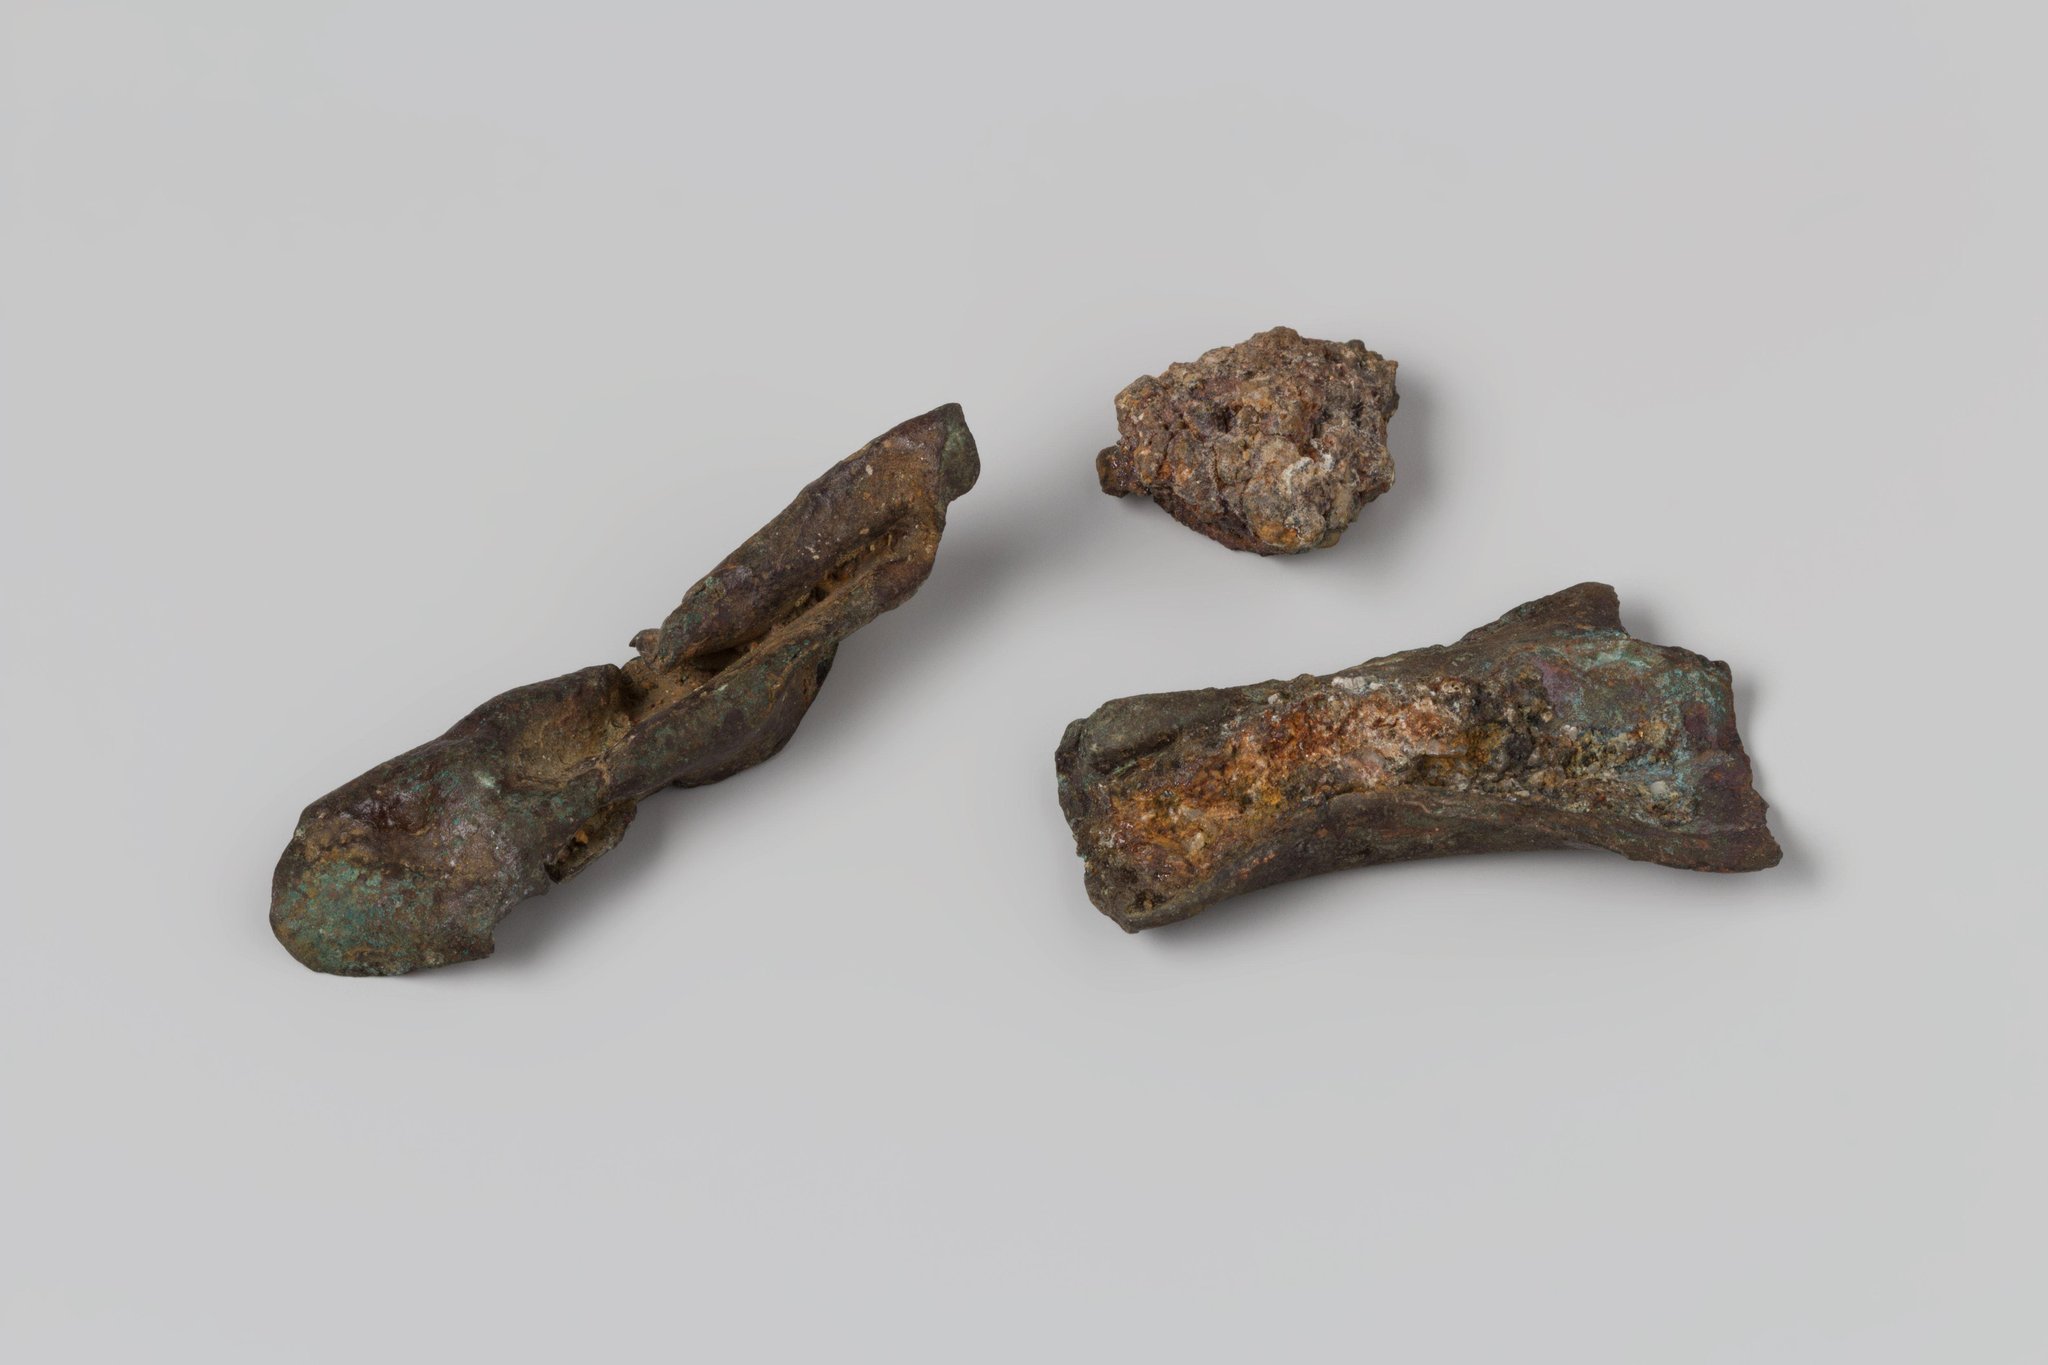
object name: scheepswrakvondst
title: Fragmenten van koper uit het wrak van de Oost-Indiëvaarder Hollandia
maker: Anonymous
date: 1700-1743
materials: copper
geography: netherlands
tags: verenigde oostindische compagnie, hollandia (schip), annet